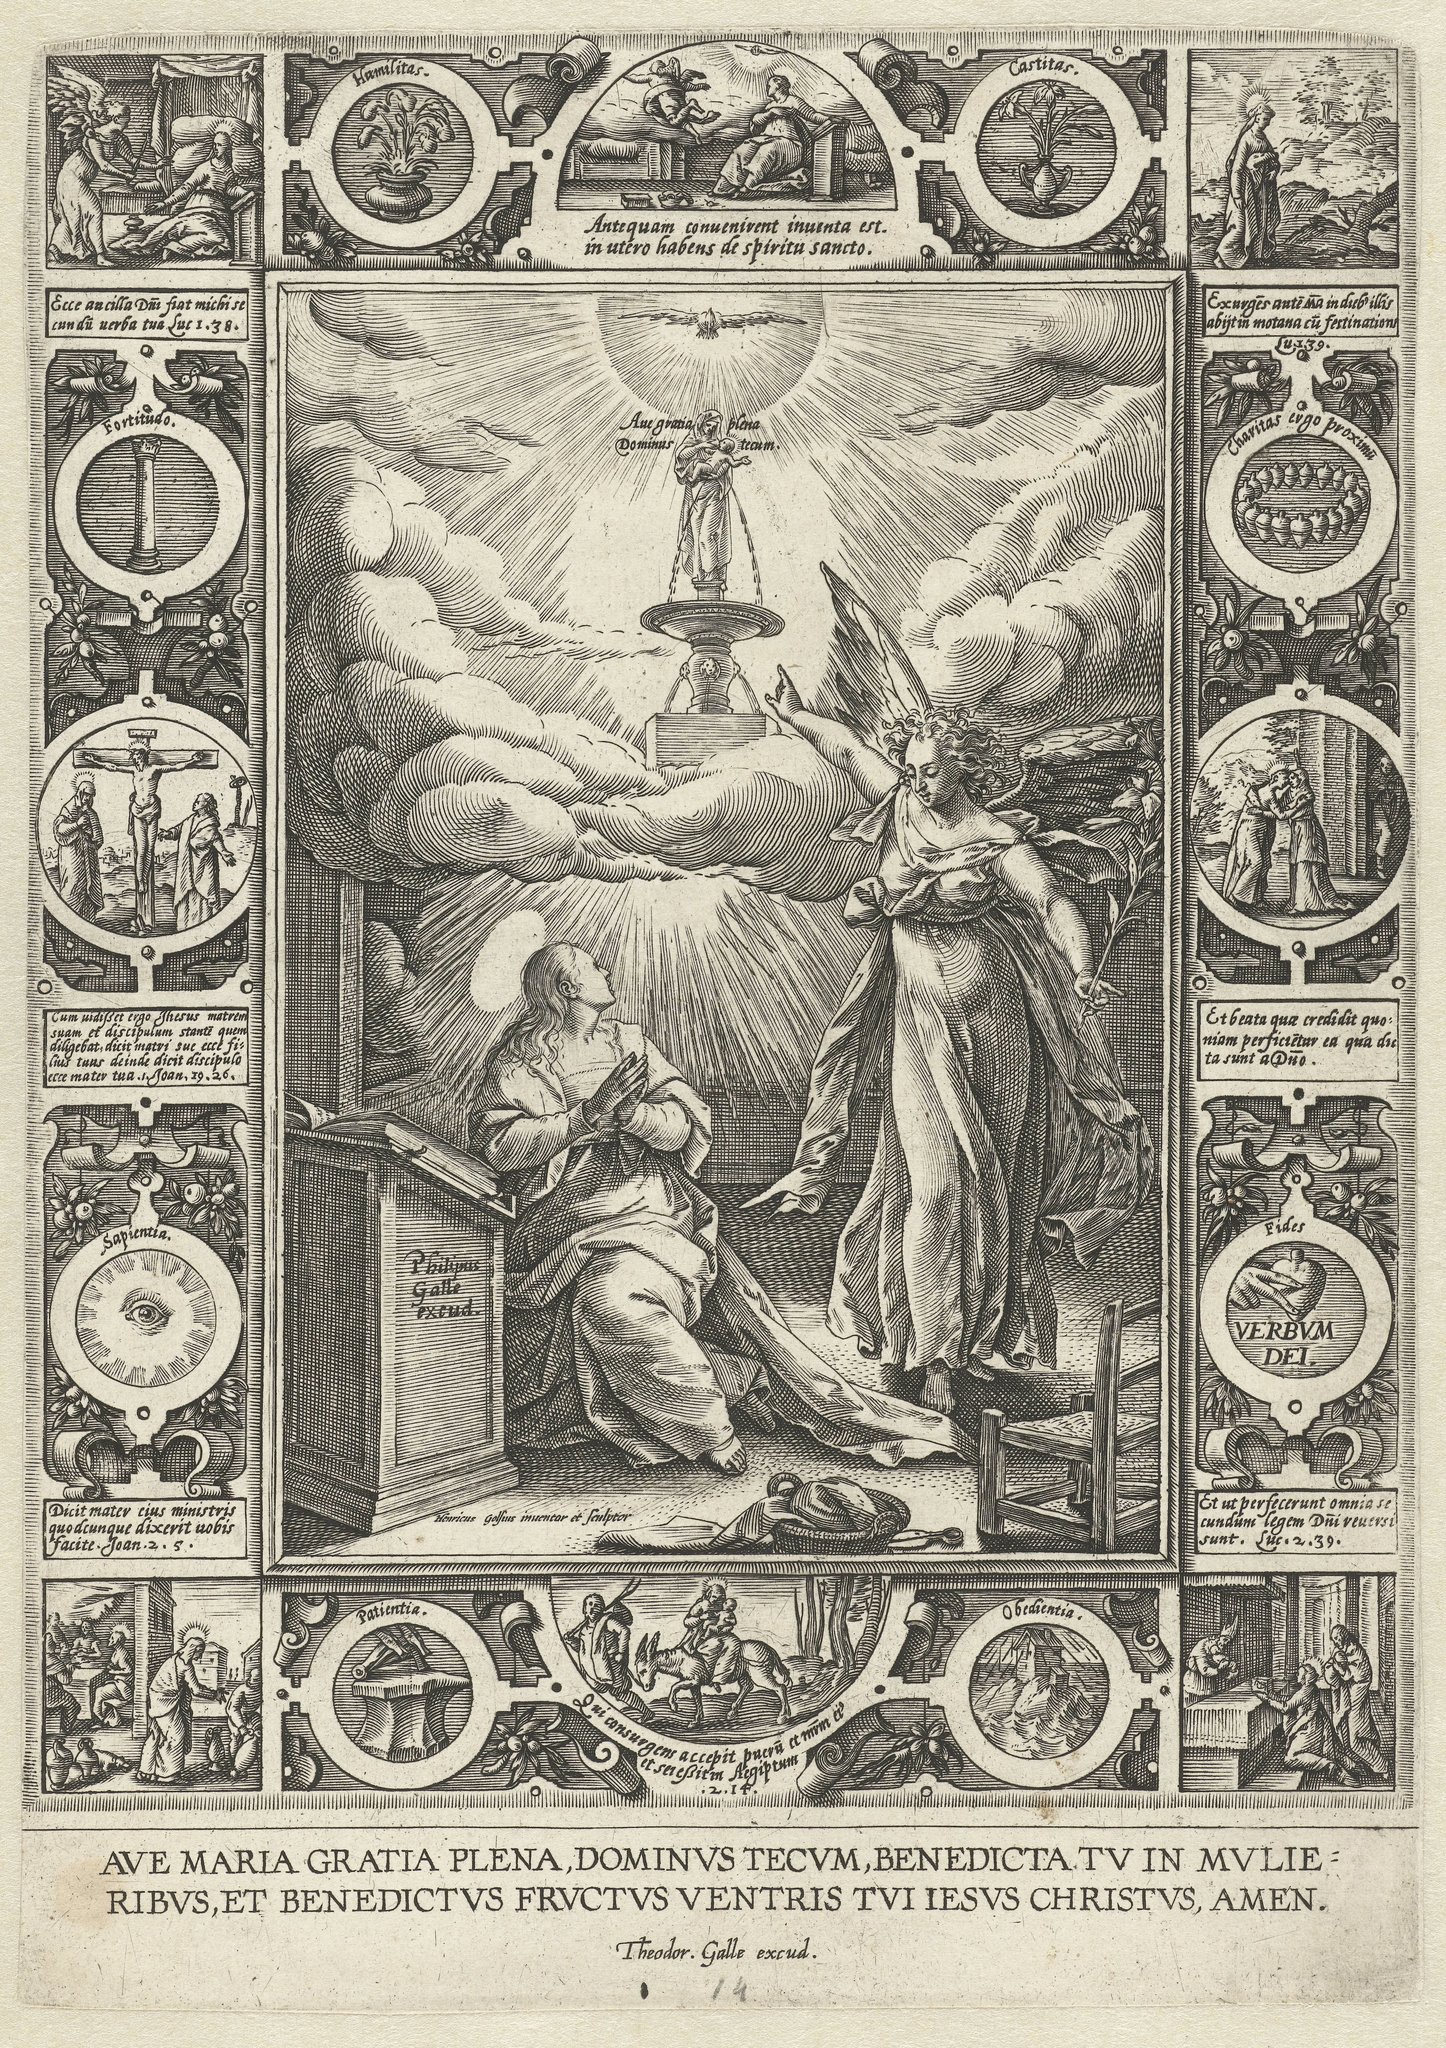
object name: print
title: Allegorische scènes uit het leven van Christus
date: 1578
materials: paper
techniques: engraving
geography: antwerp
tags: the annunciation: mary, usually reading, is visited by the angel (sometimes a woman overhears the conversation)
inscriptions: inscription: ‘Philippus Galle excud.’, inscription: ‘Theodor. Galle excud.’, collector's mark: Lugt 240, signature: ‘Henricus Golsius inuentor et Sculptor’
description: Aankondiging van de geboorte van Christus aan Maria. Rondom de voorstelling een omlijsting met diverse scènes uit het leven van Christus gecombineerd met allegorische elementen. In de marge onderaan twee regels Latijn. Deze prent is onderdeel van een serie van zes allegorische scènes uit het leven van Christus.